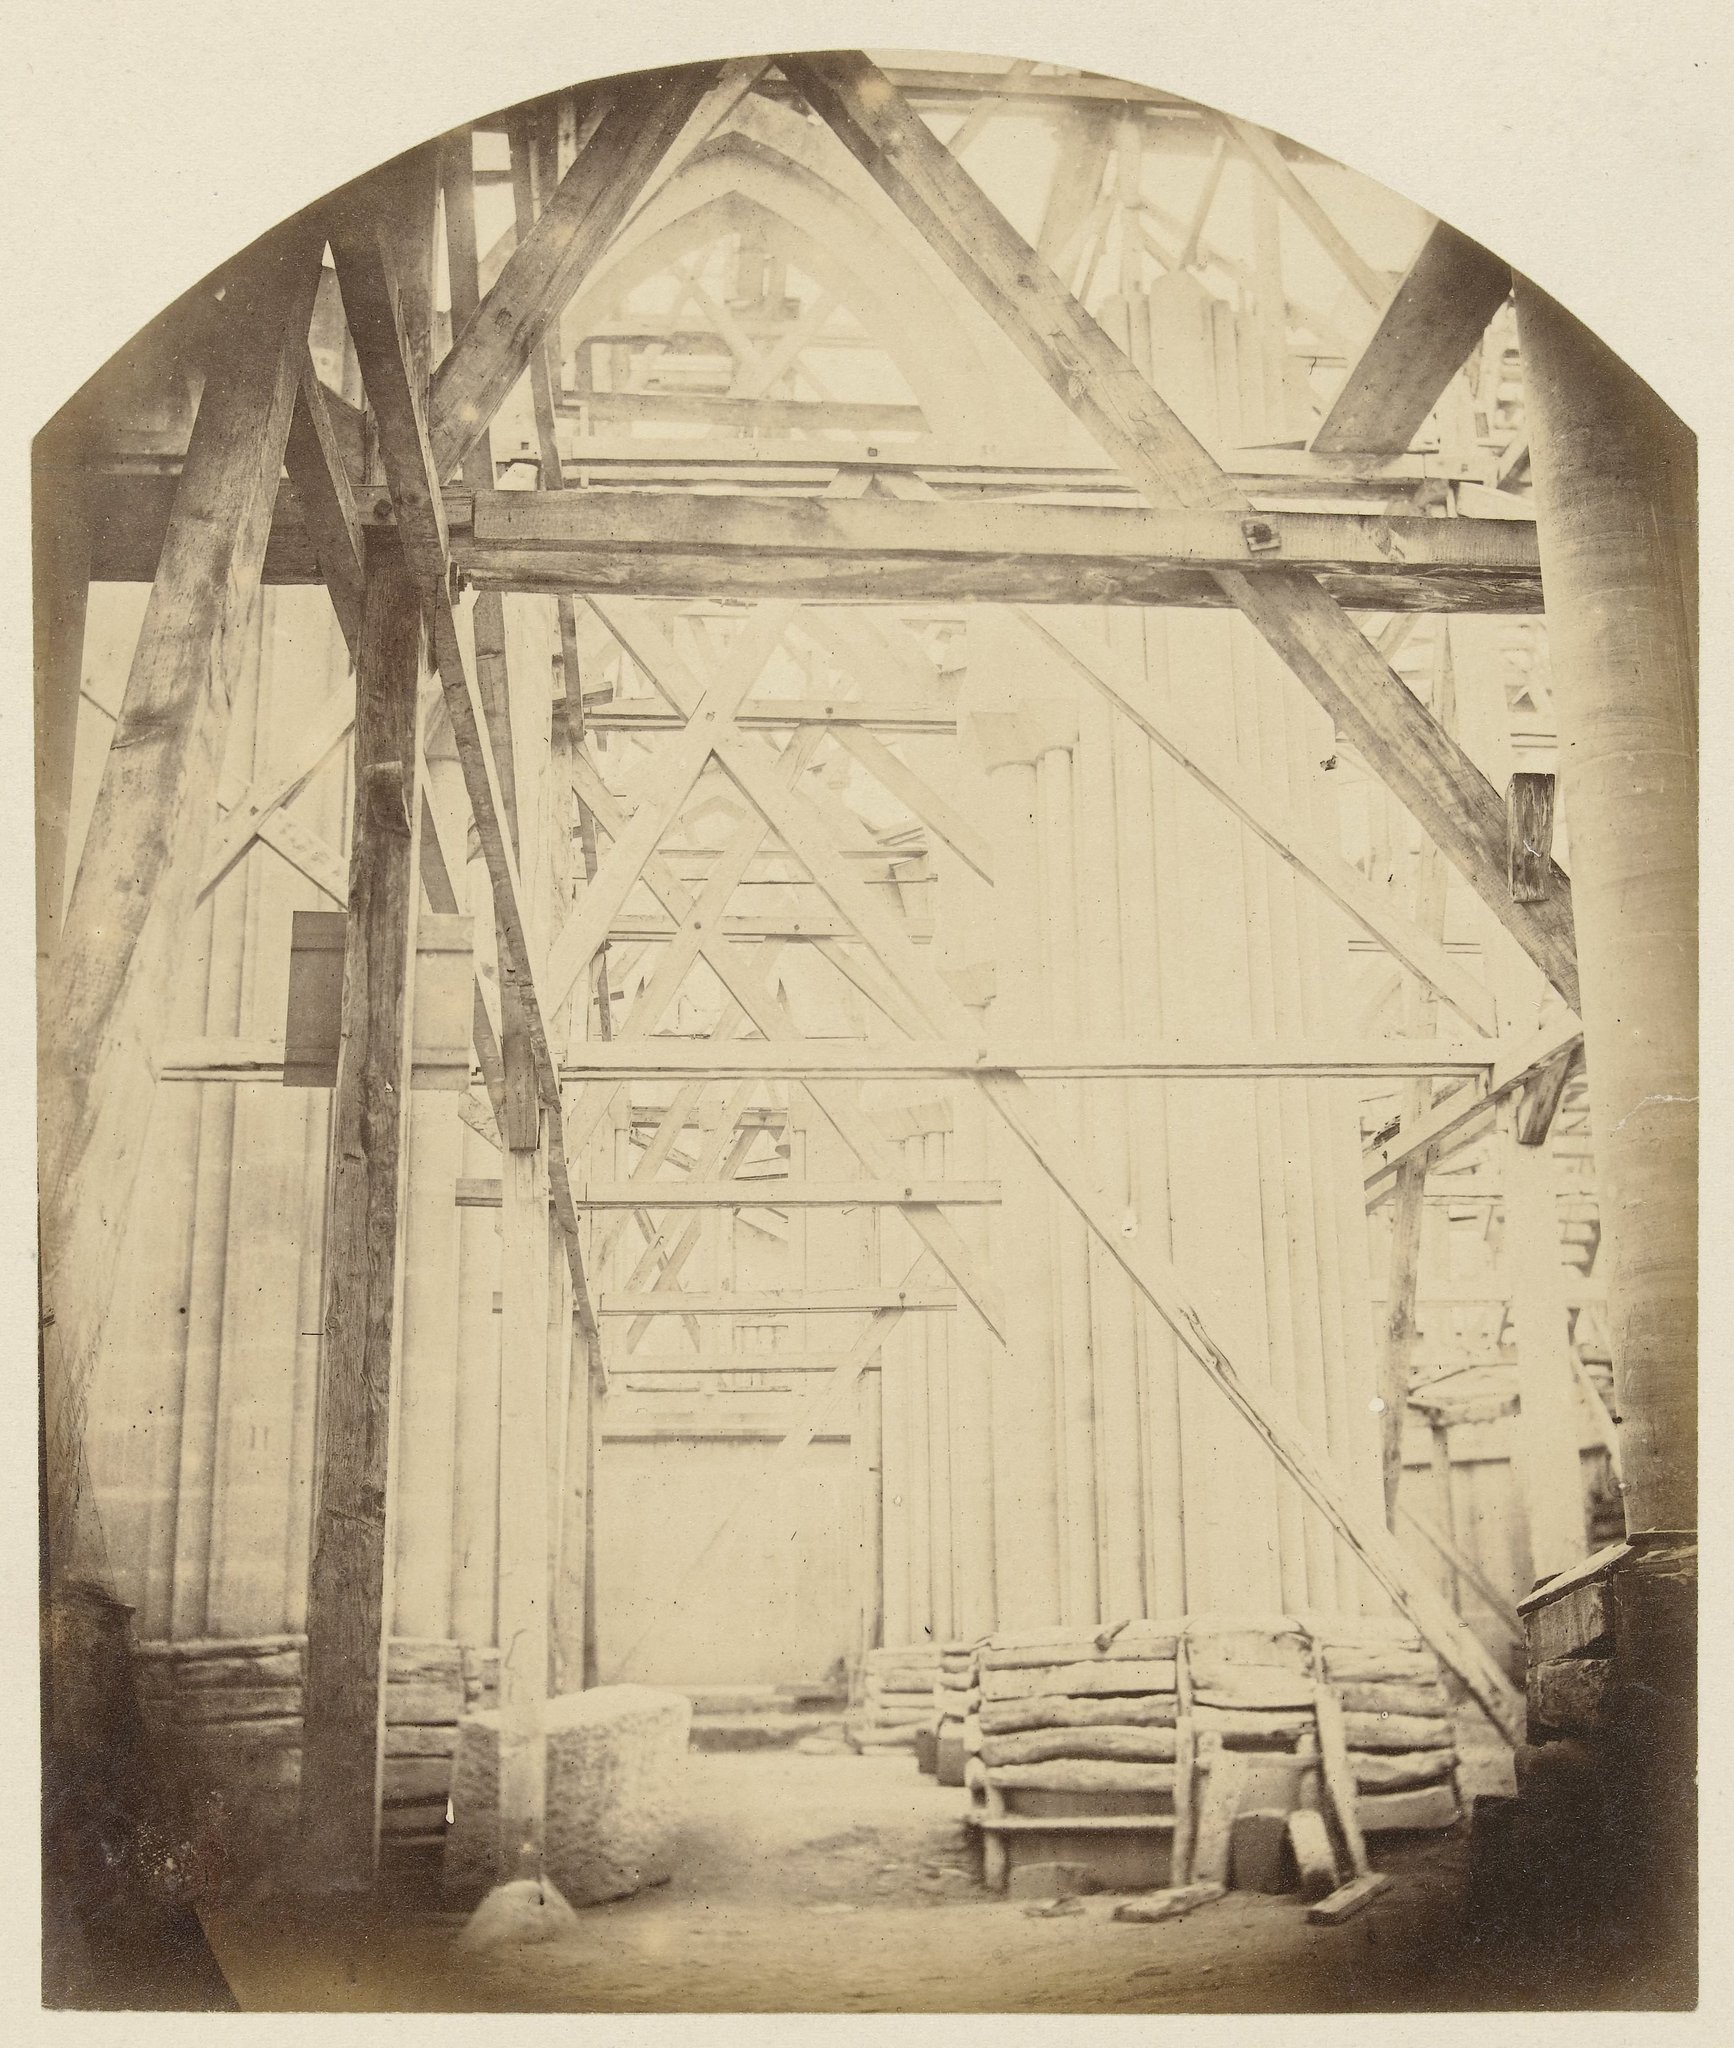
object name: photograph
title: Église Saint-Vincent-de-Paul te Marseille in aanbouw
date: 1855-1860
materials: cardboard, paper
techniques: albumen print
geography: marseille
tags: building-site, marseille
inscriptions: inscription: ‘No. 7 Naf laterale côté nord et son abside’